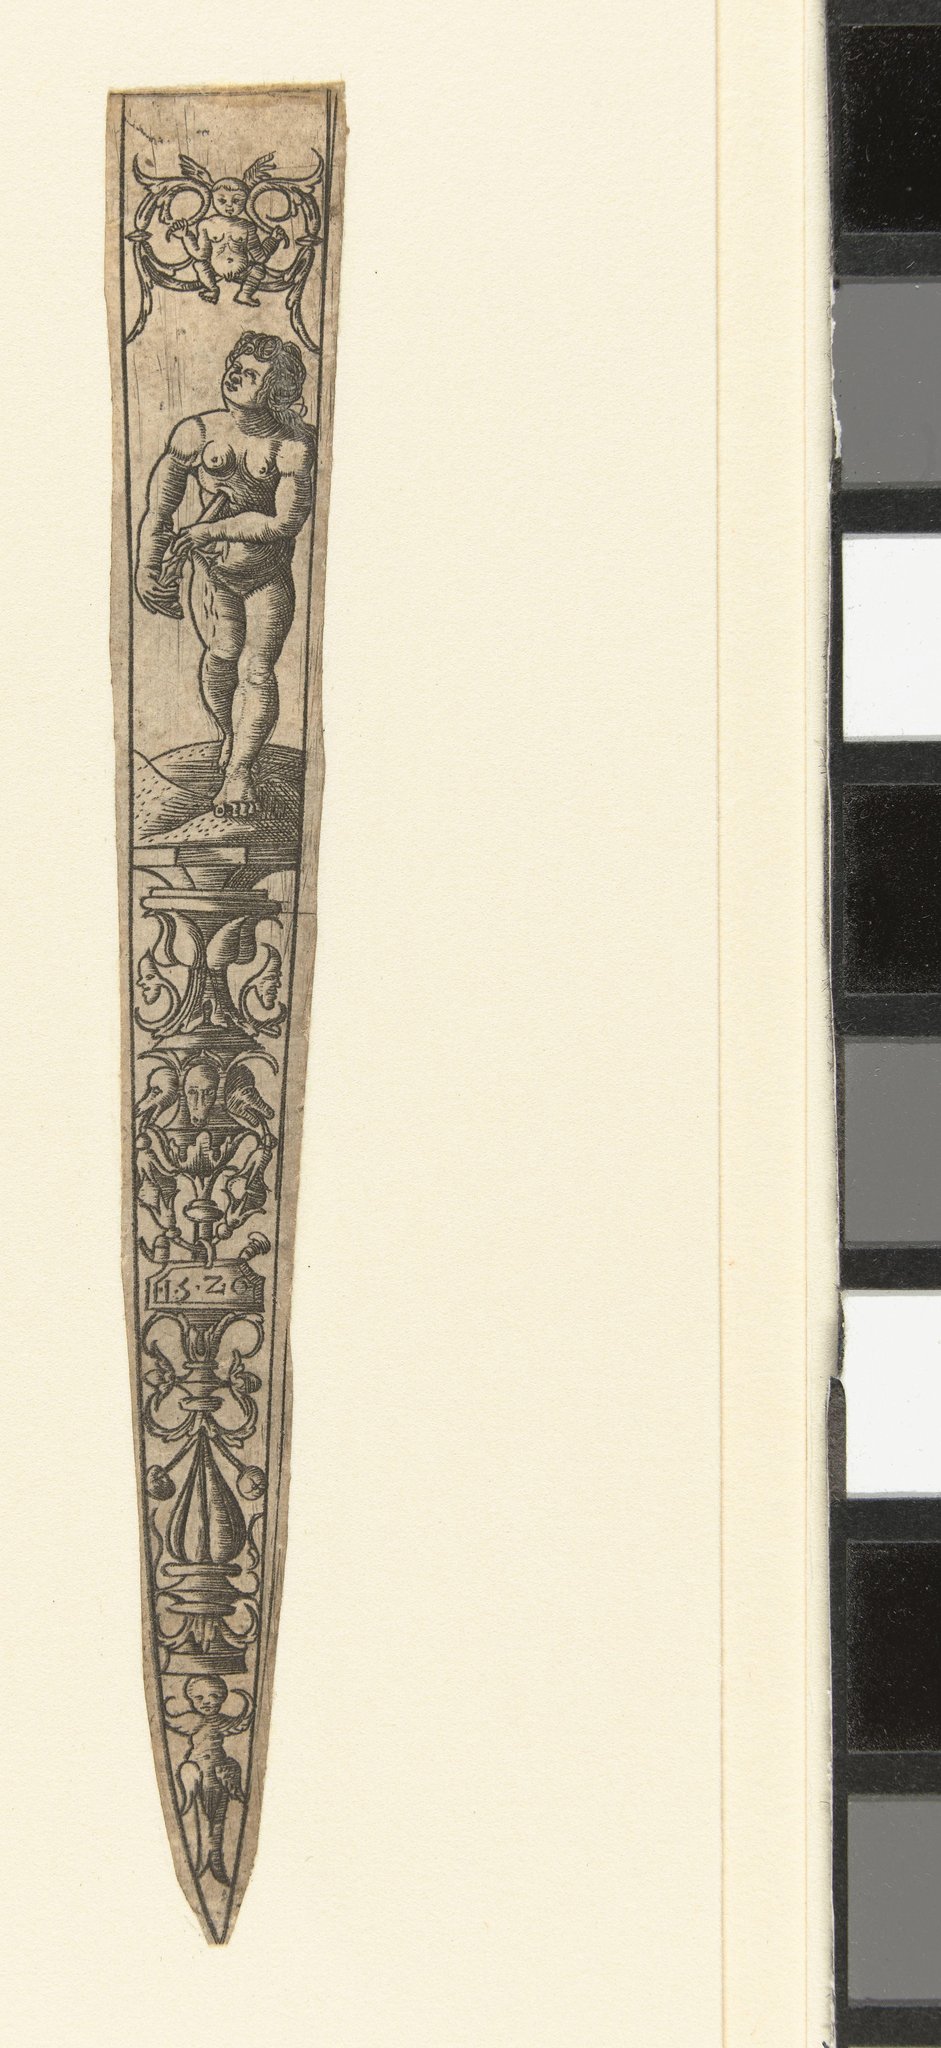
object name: ornament print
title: Scheden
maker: Anonymous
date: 1500-1526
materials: paper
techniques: engraving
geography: germany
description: Het onderste gedeelte is gedecoreerd met kandelabers met bladranken en grotesken. Helemaal bovenaan zit een putto tussen twee voluten van bladranken.